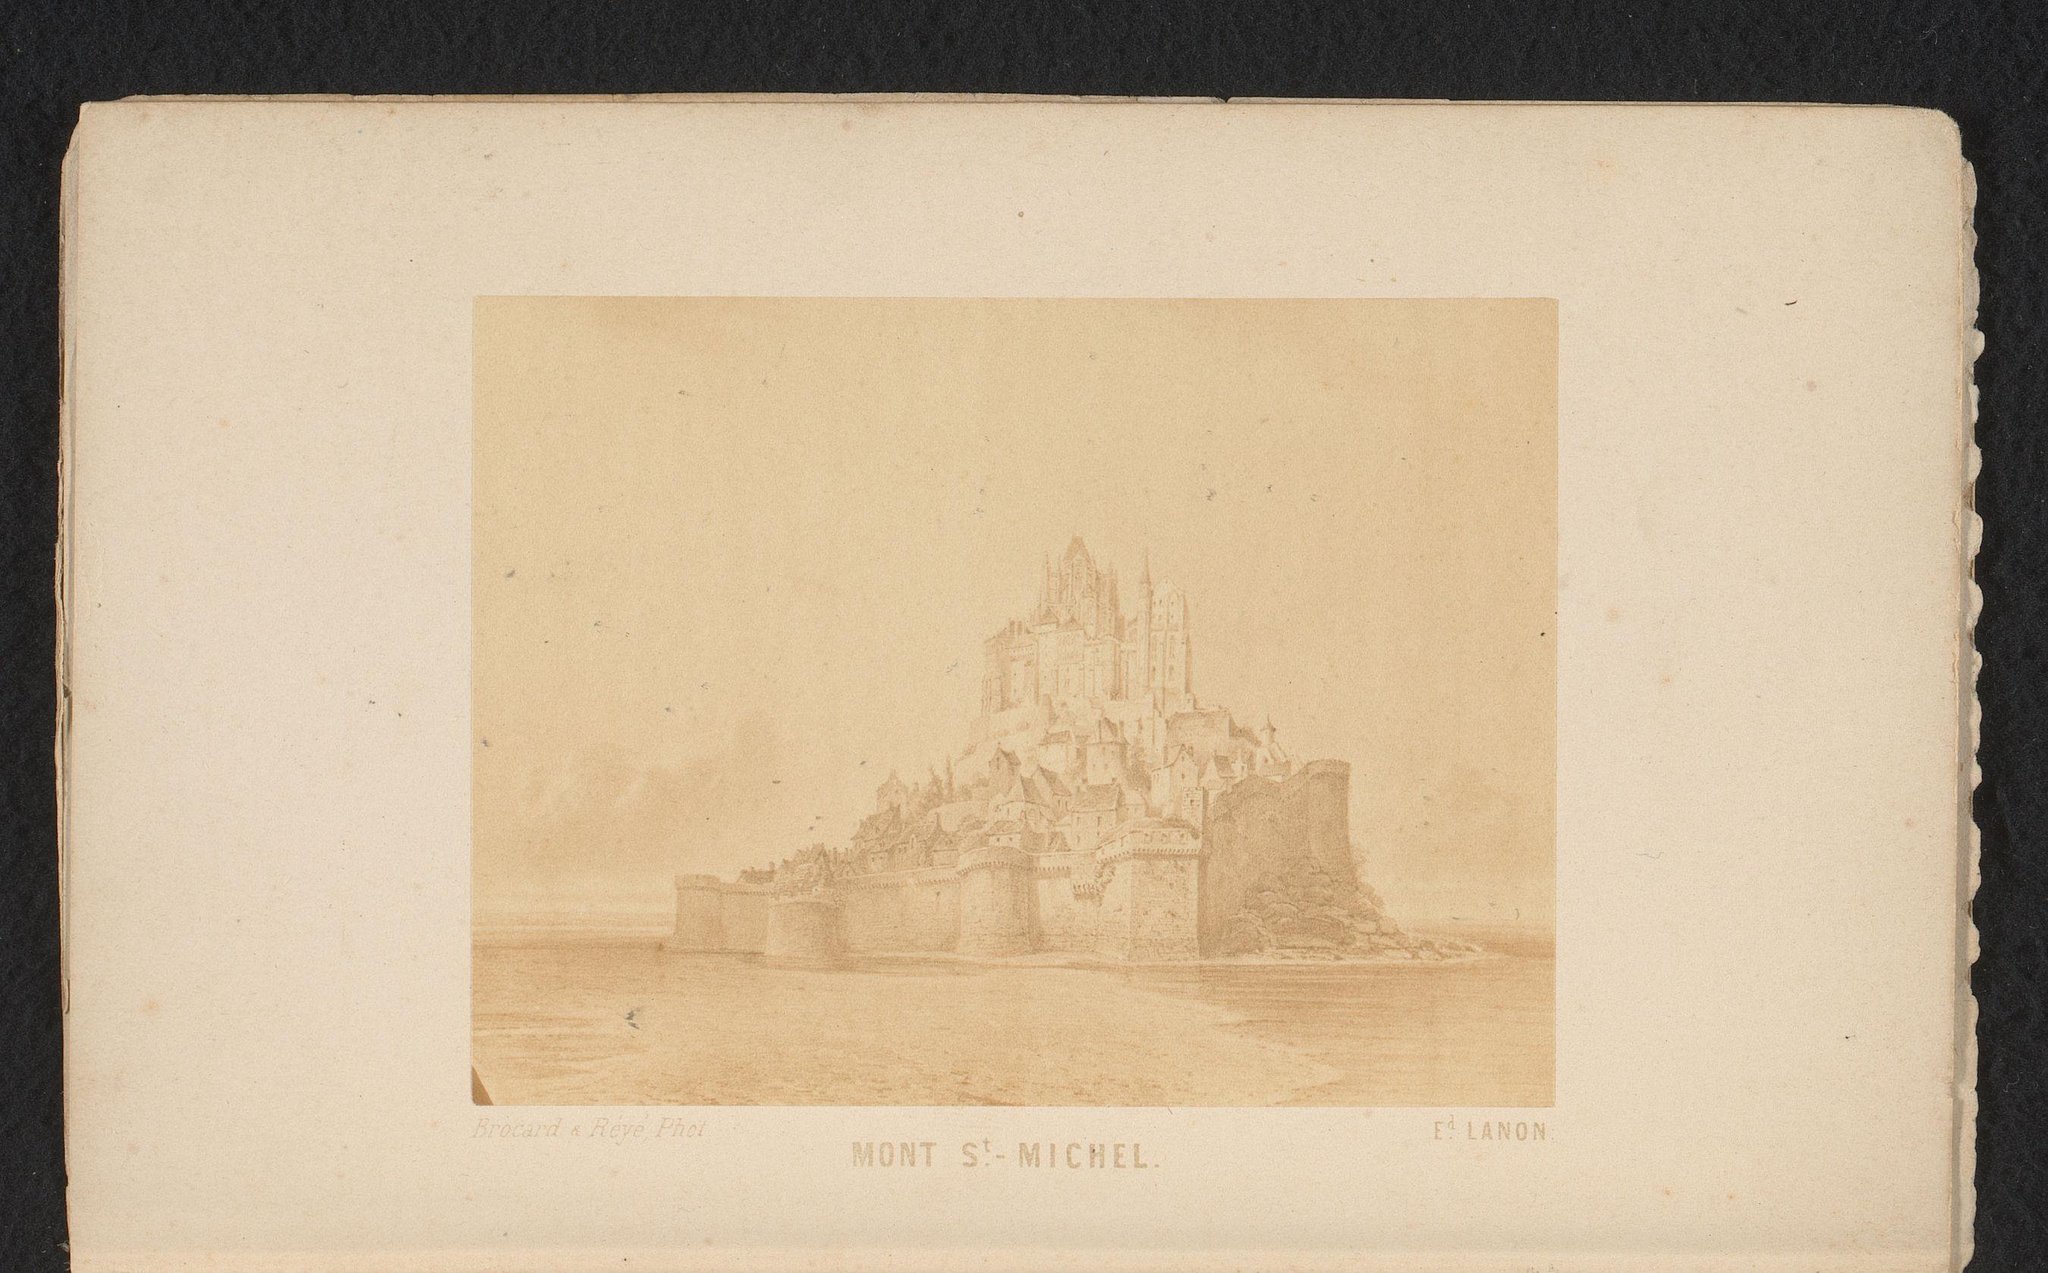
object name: reproduction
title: Fotoreproductie van een getekend gezicht op de Mont Saint-Michel door Edmond Lanon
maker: edmond lanon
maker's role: designer, draughtsman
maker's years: 1830-1871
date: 1861-1866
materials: paper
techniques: albumen print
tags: island, abbey, monastery, convent ~ roman catholic church